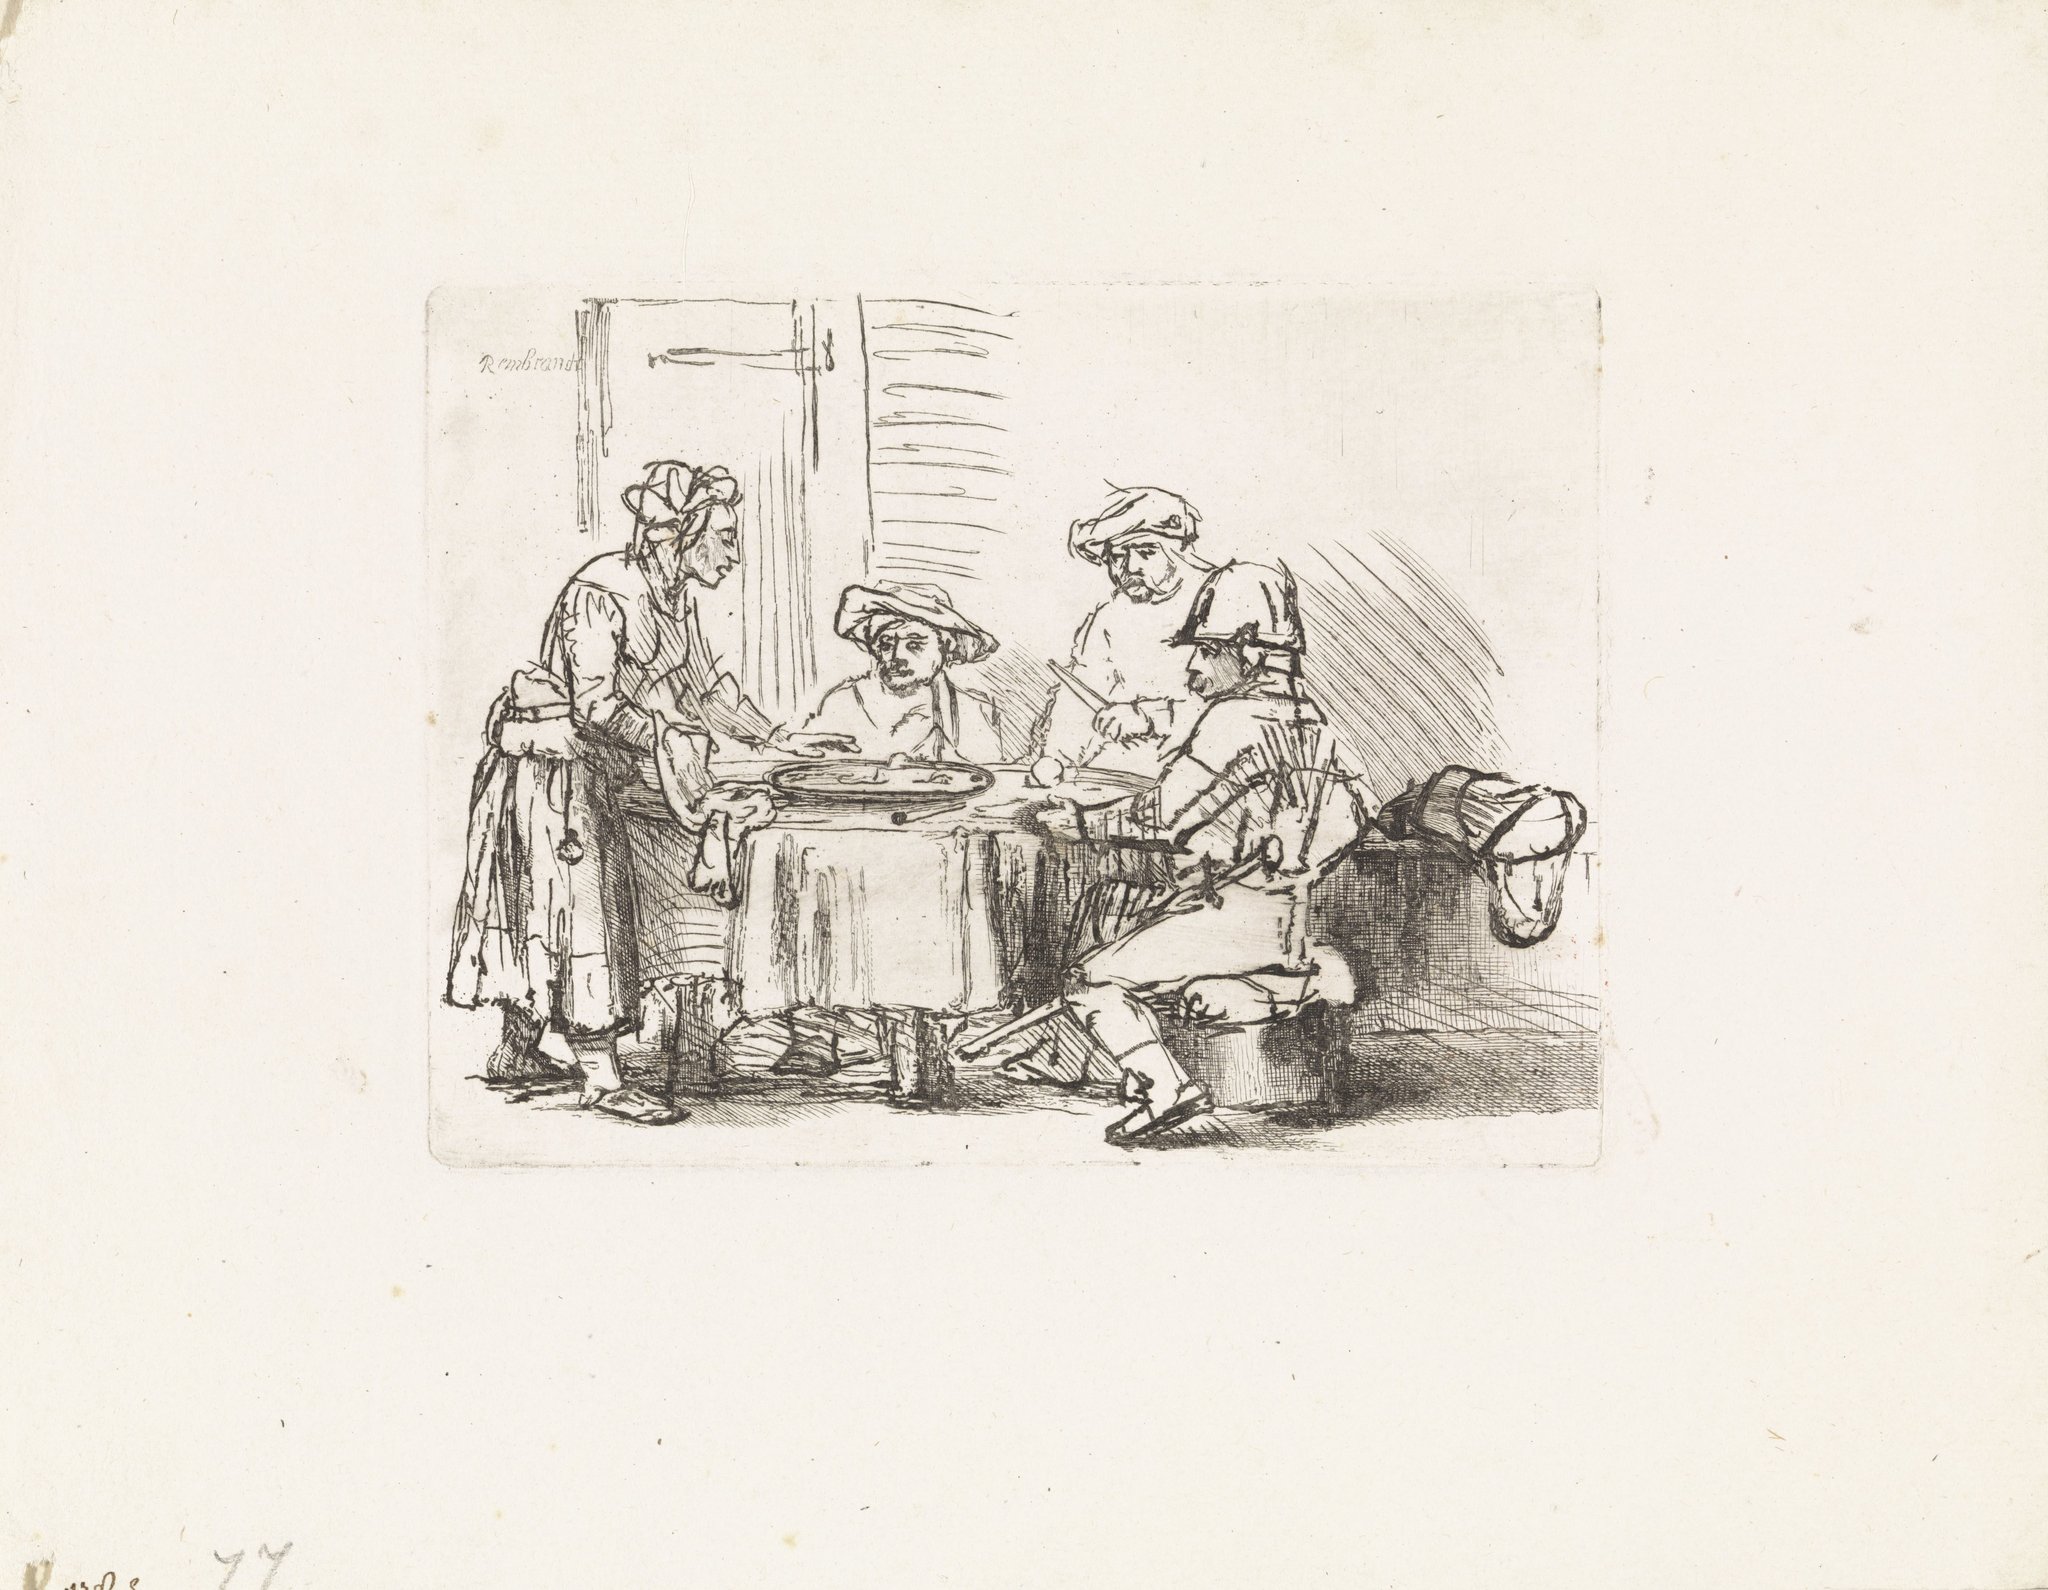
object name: print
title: Verscheide gedagten in het koper gebragt naar de origenelen teekeningen en schetschen van Rembrandt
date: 1696-1727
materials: paper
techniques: engraving, etching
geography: amsterdam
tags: saul disguised as a soldier goes to the witch of endor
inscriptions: collector's mark: Lugt 240, number: ‘378,3.’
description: Koning Saul en zijn knechten zitten rond een tafel. De heks van Endor roept op verzoek van Saul de geest op van de profeet Samuel, diens voormalige adviseur. De profeet voorspelt dat Saul de oorlog zal verliezen en dat zijn zonen zullen sneuvelen omdat hij zich van God had afgekeerd.